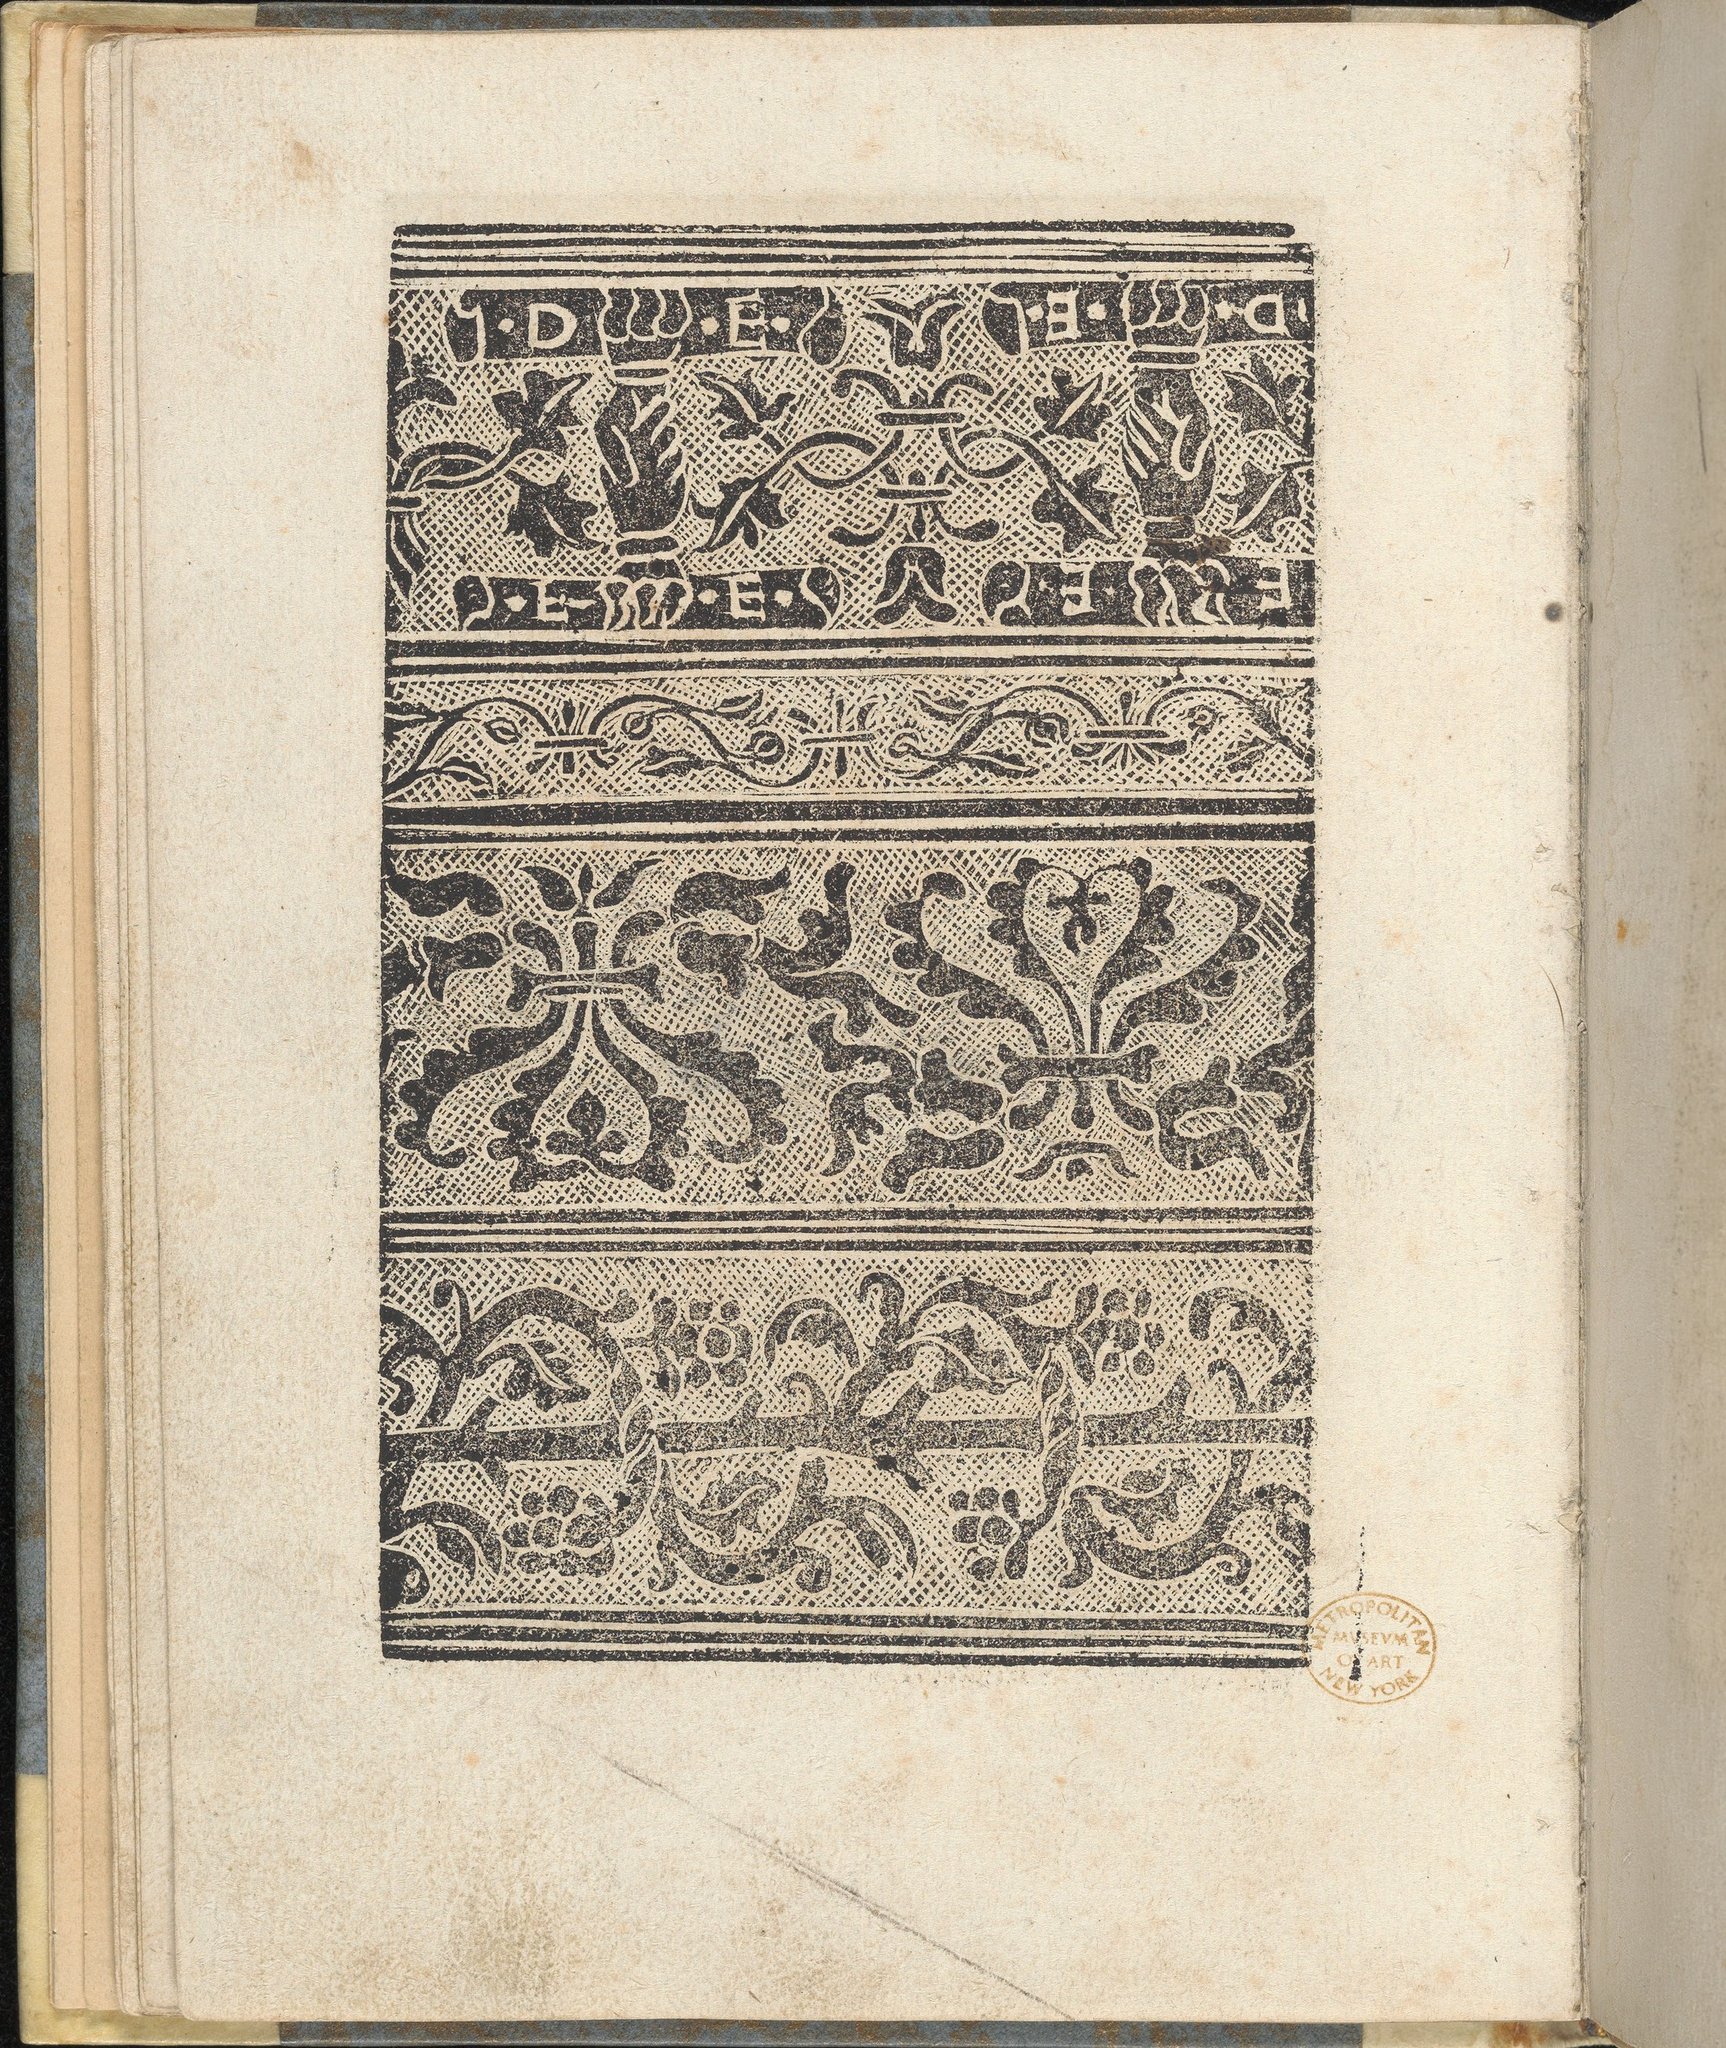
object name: book print ornament architecture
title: Ein ney Furmbüchlein, Page 17, verso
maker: johann schönsperger the younger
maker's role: publisher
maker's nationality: german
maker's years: 1490-1550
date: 1525-1529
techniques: woodcut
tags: flowers